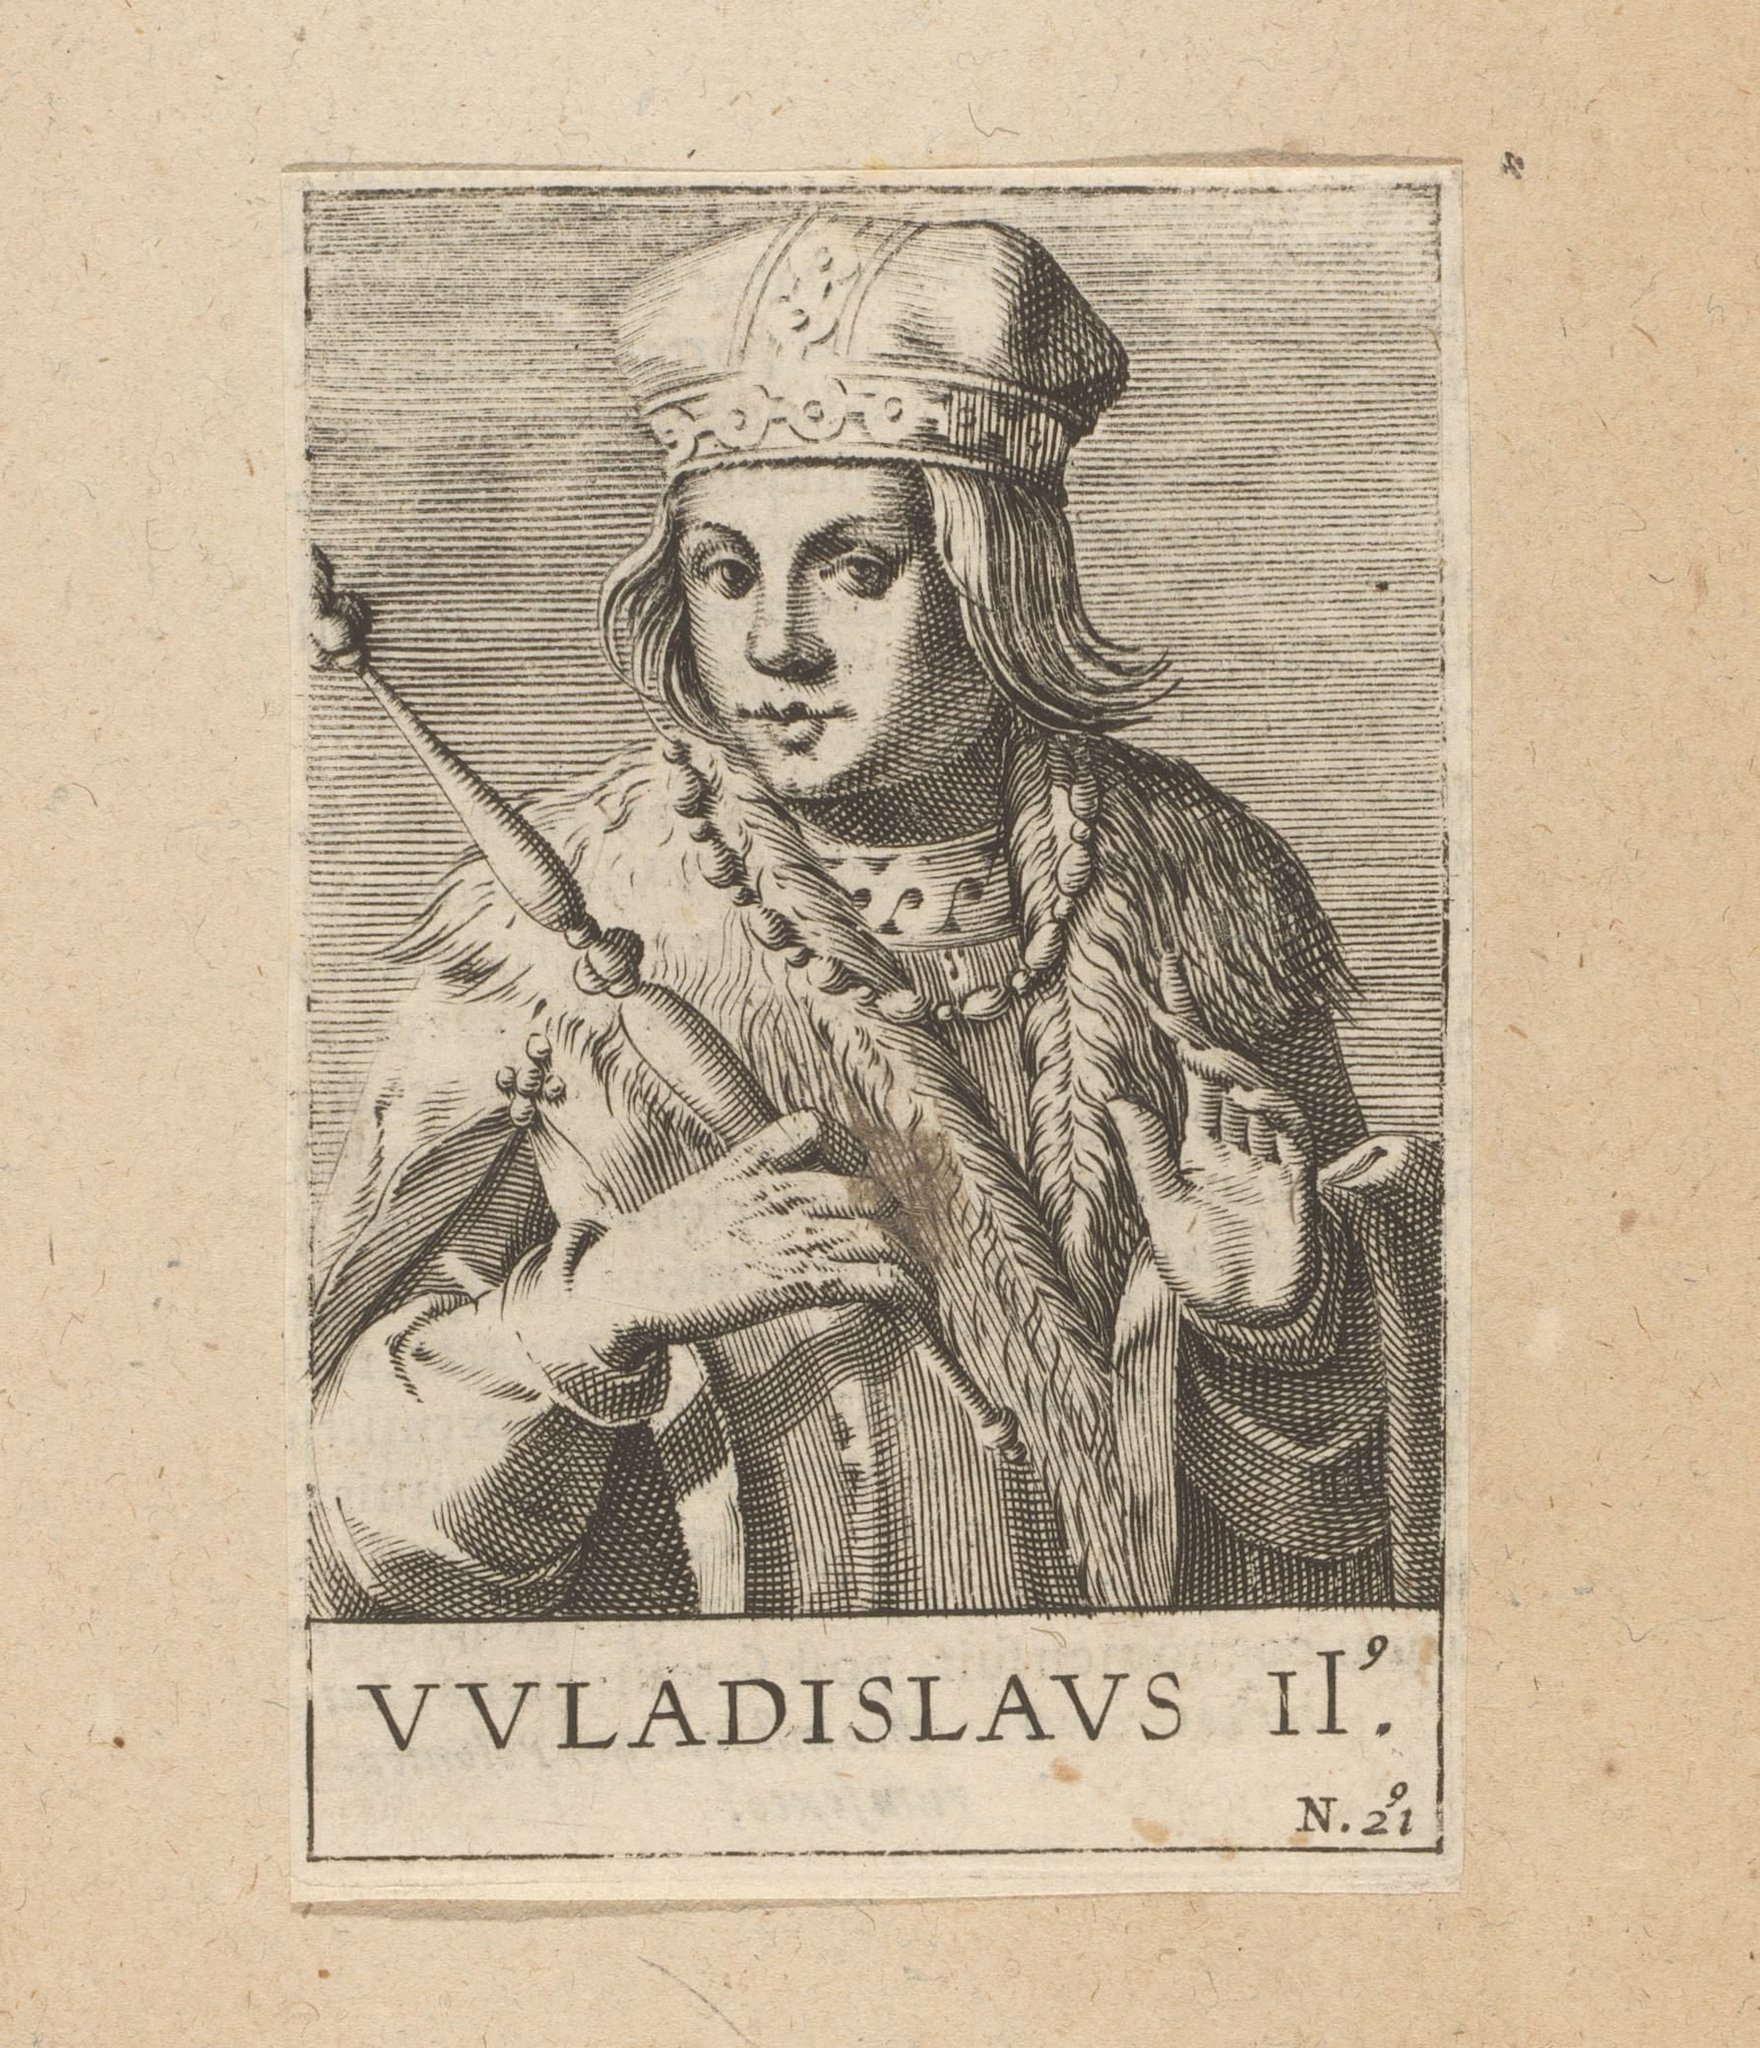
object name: print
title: Portret van Wladislaus de Balling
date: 1574-1594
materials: paper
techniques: woodcut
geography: cologne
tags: historical persons, ruler, sovereign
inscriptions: collector's mark: Lugt 240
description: Prent gebruikt in: Mylius, Arnold. Principum et Regum Polonorum Imagines ad Vivum Expressae (...). Keulen: Gottfried von Kempen, 1594.